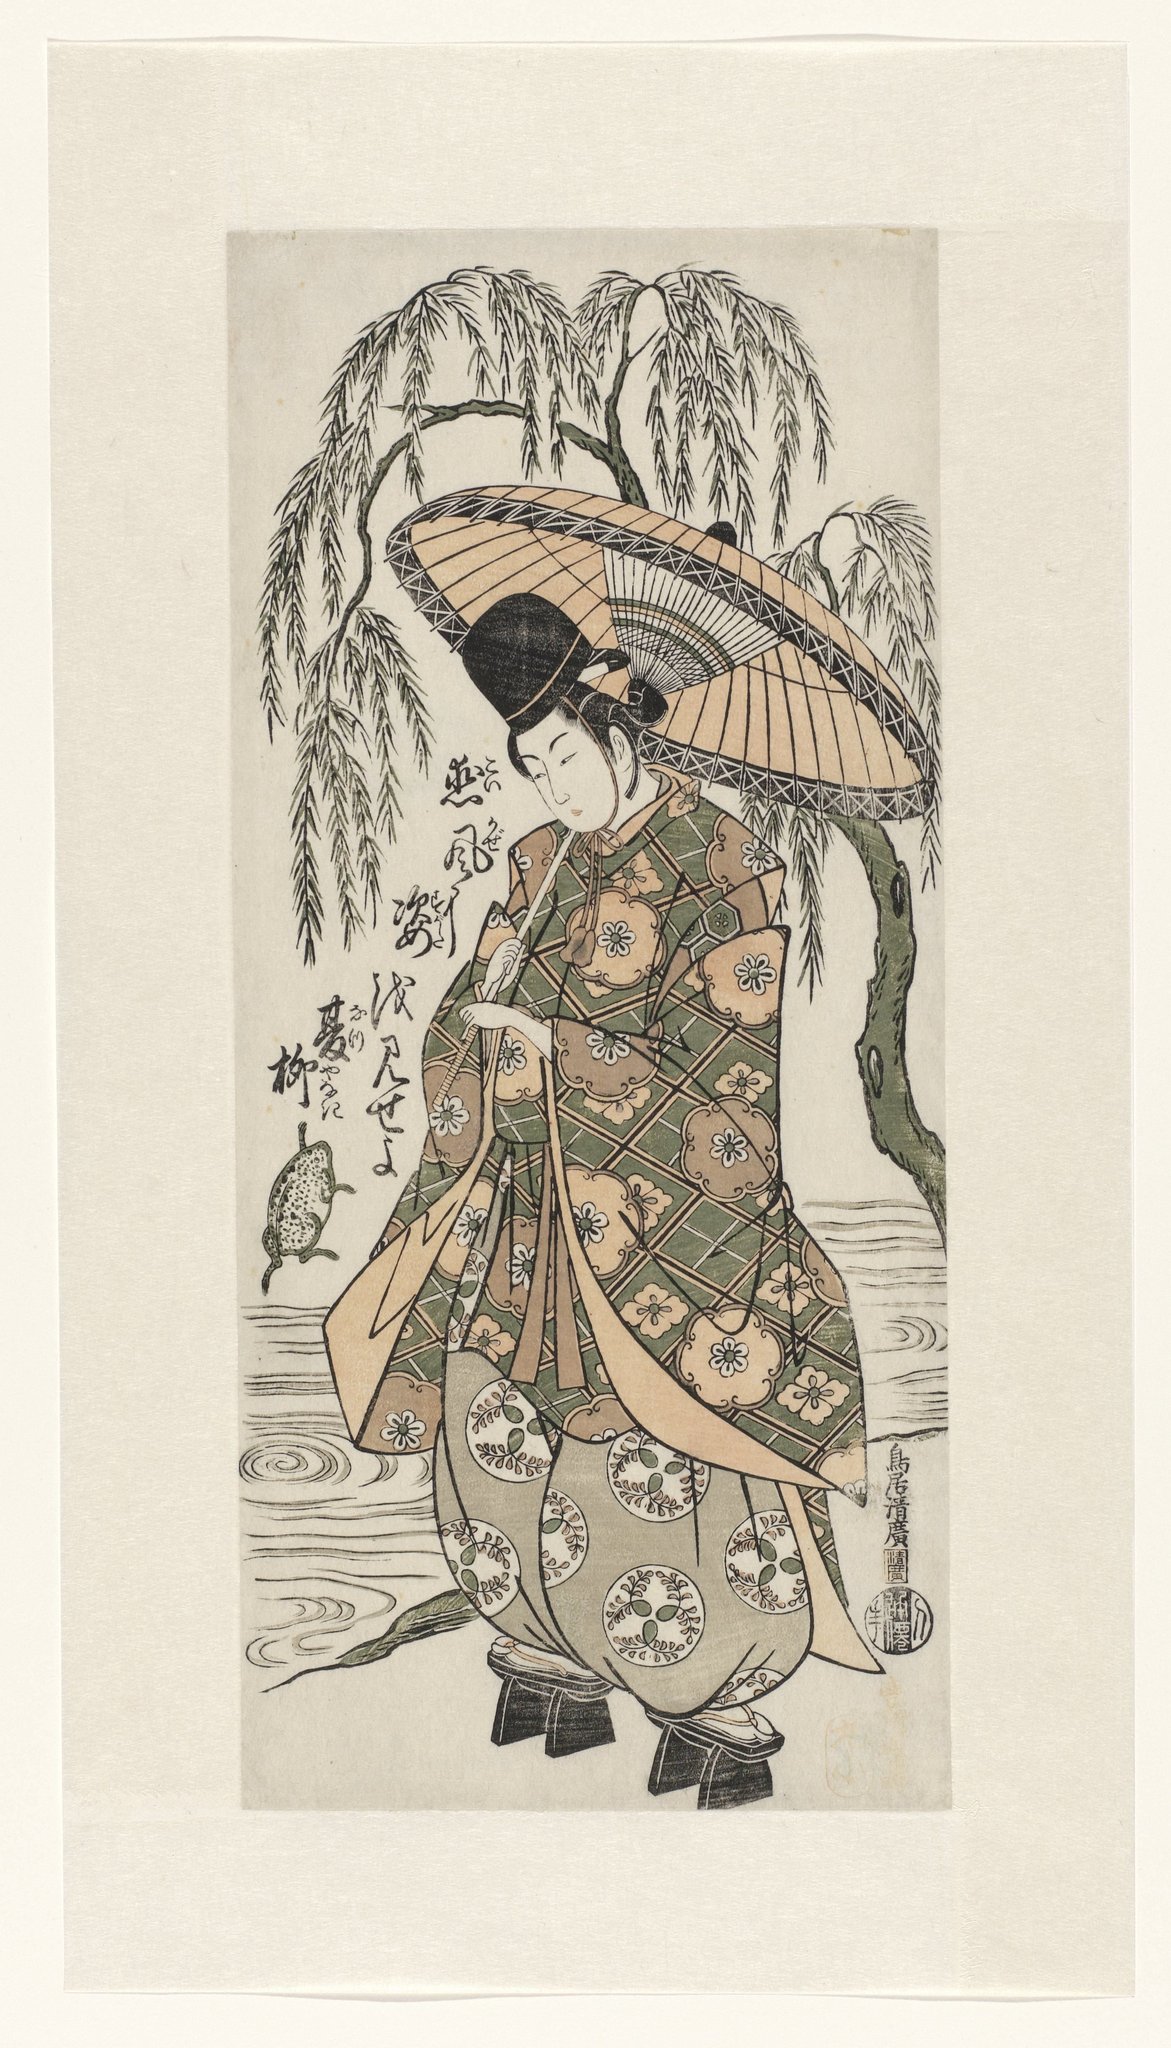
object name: print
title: Ono no Tofu and the Frog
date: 1758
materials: paper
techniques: woodcut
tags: tailless amphibians: frog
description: Brooding about whether to give up his career as a court calligrapher, Ono no Tofu sees a frog trying to jump onto a willow branch. After many failed attempts, the frog finally succeeds. This perseverance inspires the later very famous calligrapher to never to give up. This early two-colour print in pink and green dates from just before the invention of the multi-colour print in Japan.